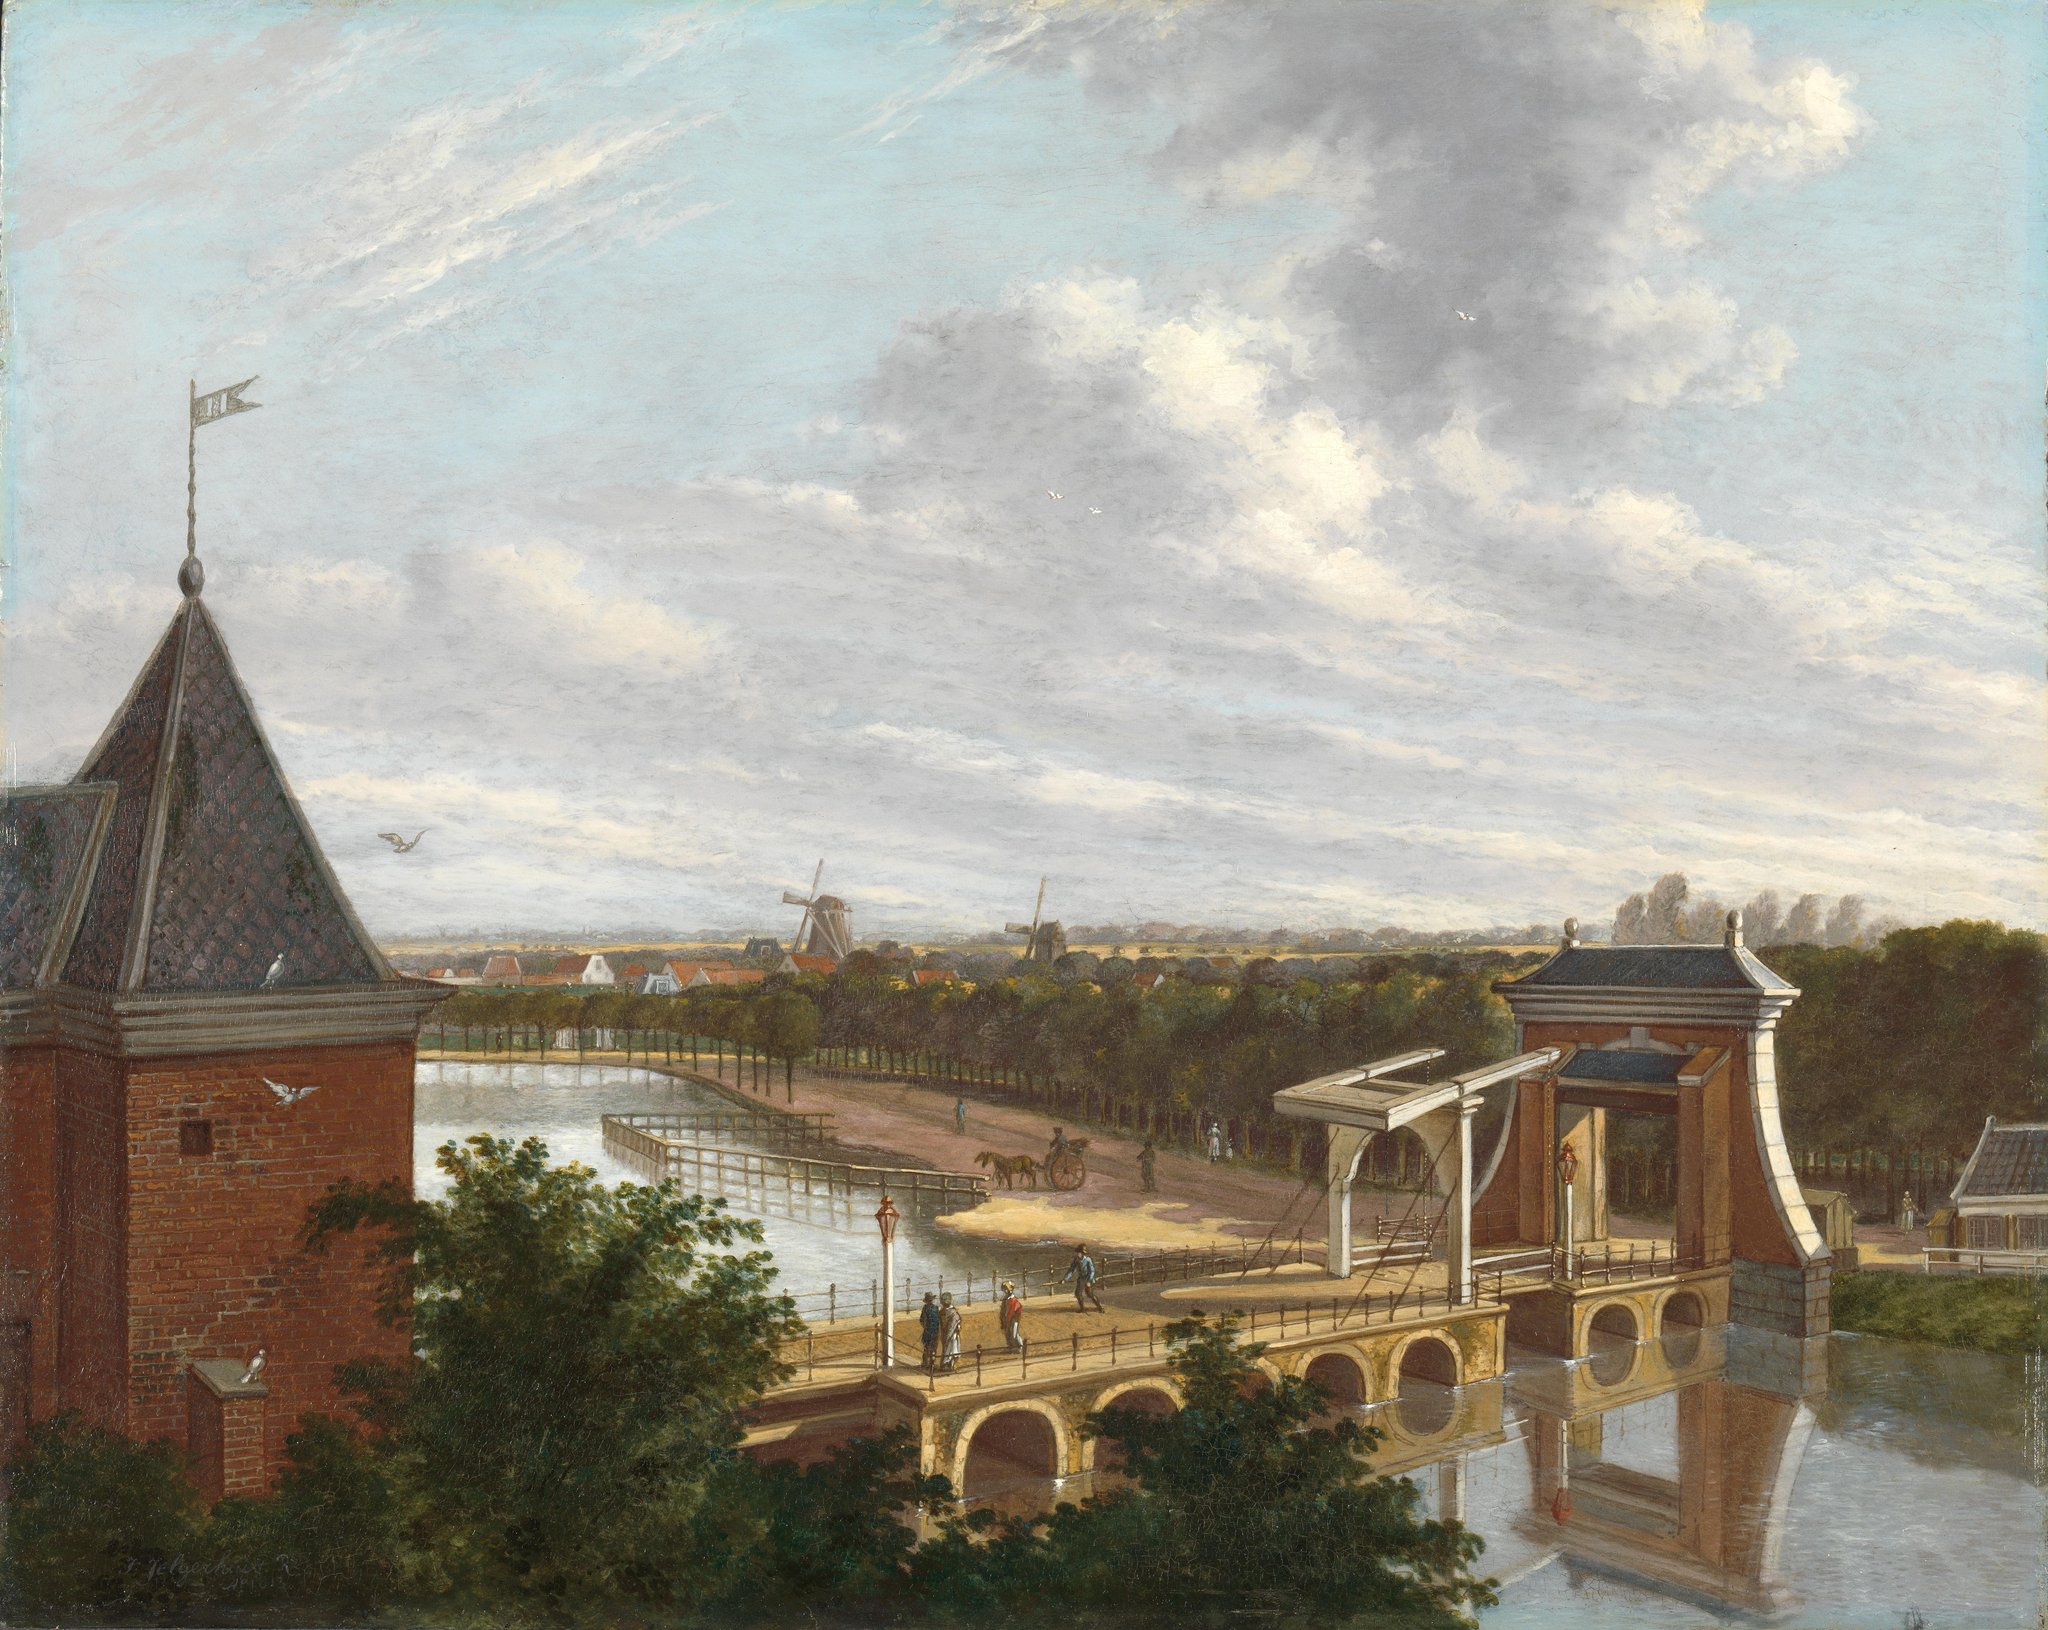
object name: painting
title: The Amsterdam Outer Canal near the Leidsepoort Seen from the Theatre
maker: johannes jelgerhuis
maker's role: draughtsman, painter, print maker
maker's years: 1770-1836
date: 1813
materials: oil, panel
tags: windmill in landscape, city-gate, amsterdam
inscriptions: signature and date: ‘J. Jelgerhuis Rzn Aº 1813’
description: This city view was painted from the theatre on the Leidseplein, where the artist worked as an actor. At left is the tower of the Leidsepoort. From the high vantage point, one sees clearly how the canal called the Singelgracht once bordered onto countryside, which is dotted with mills and farms. The left mill marks roughly the spot where the Rijksmuseum now stands.